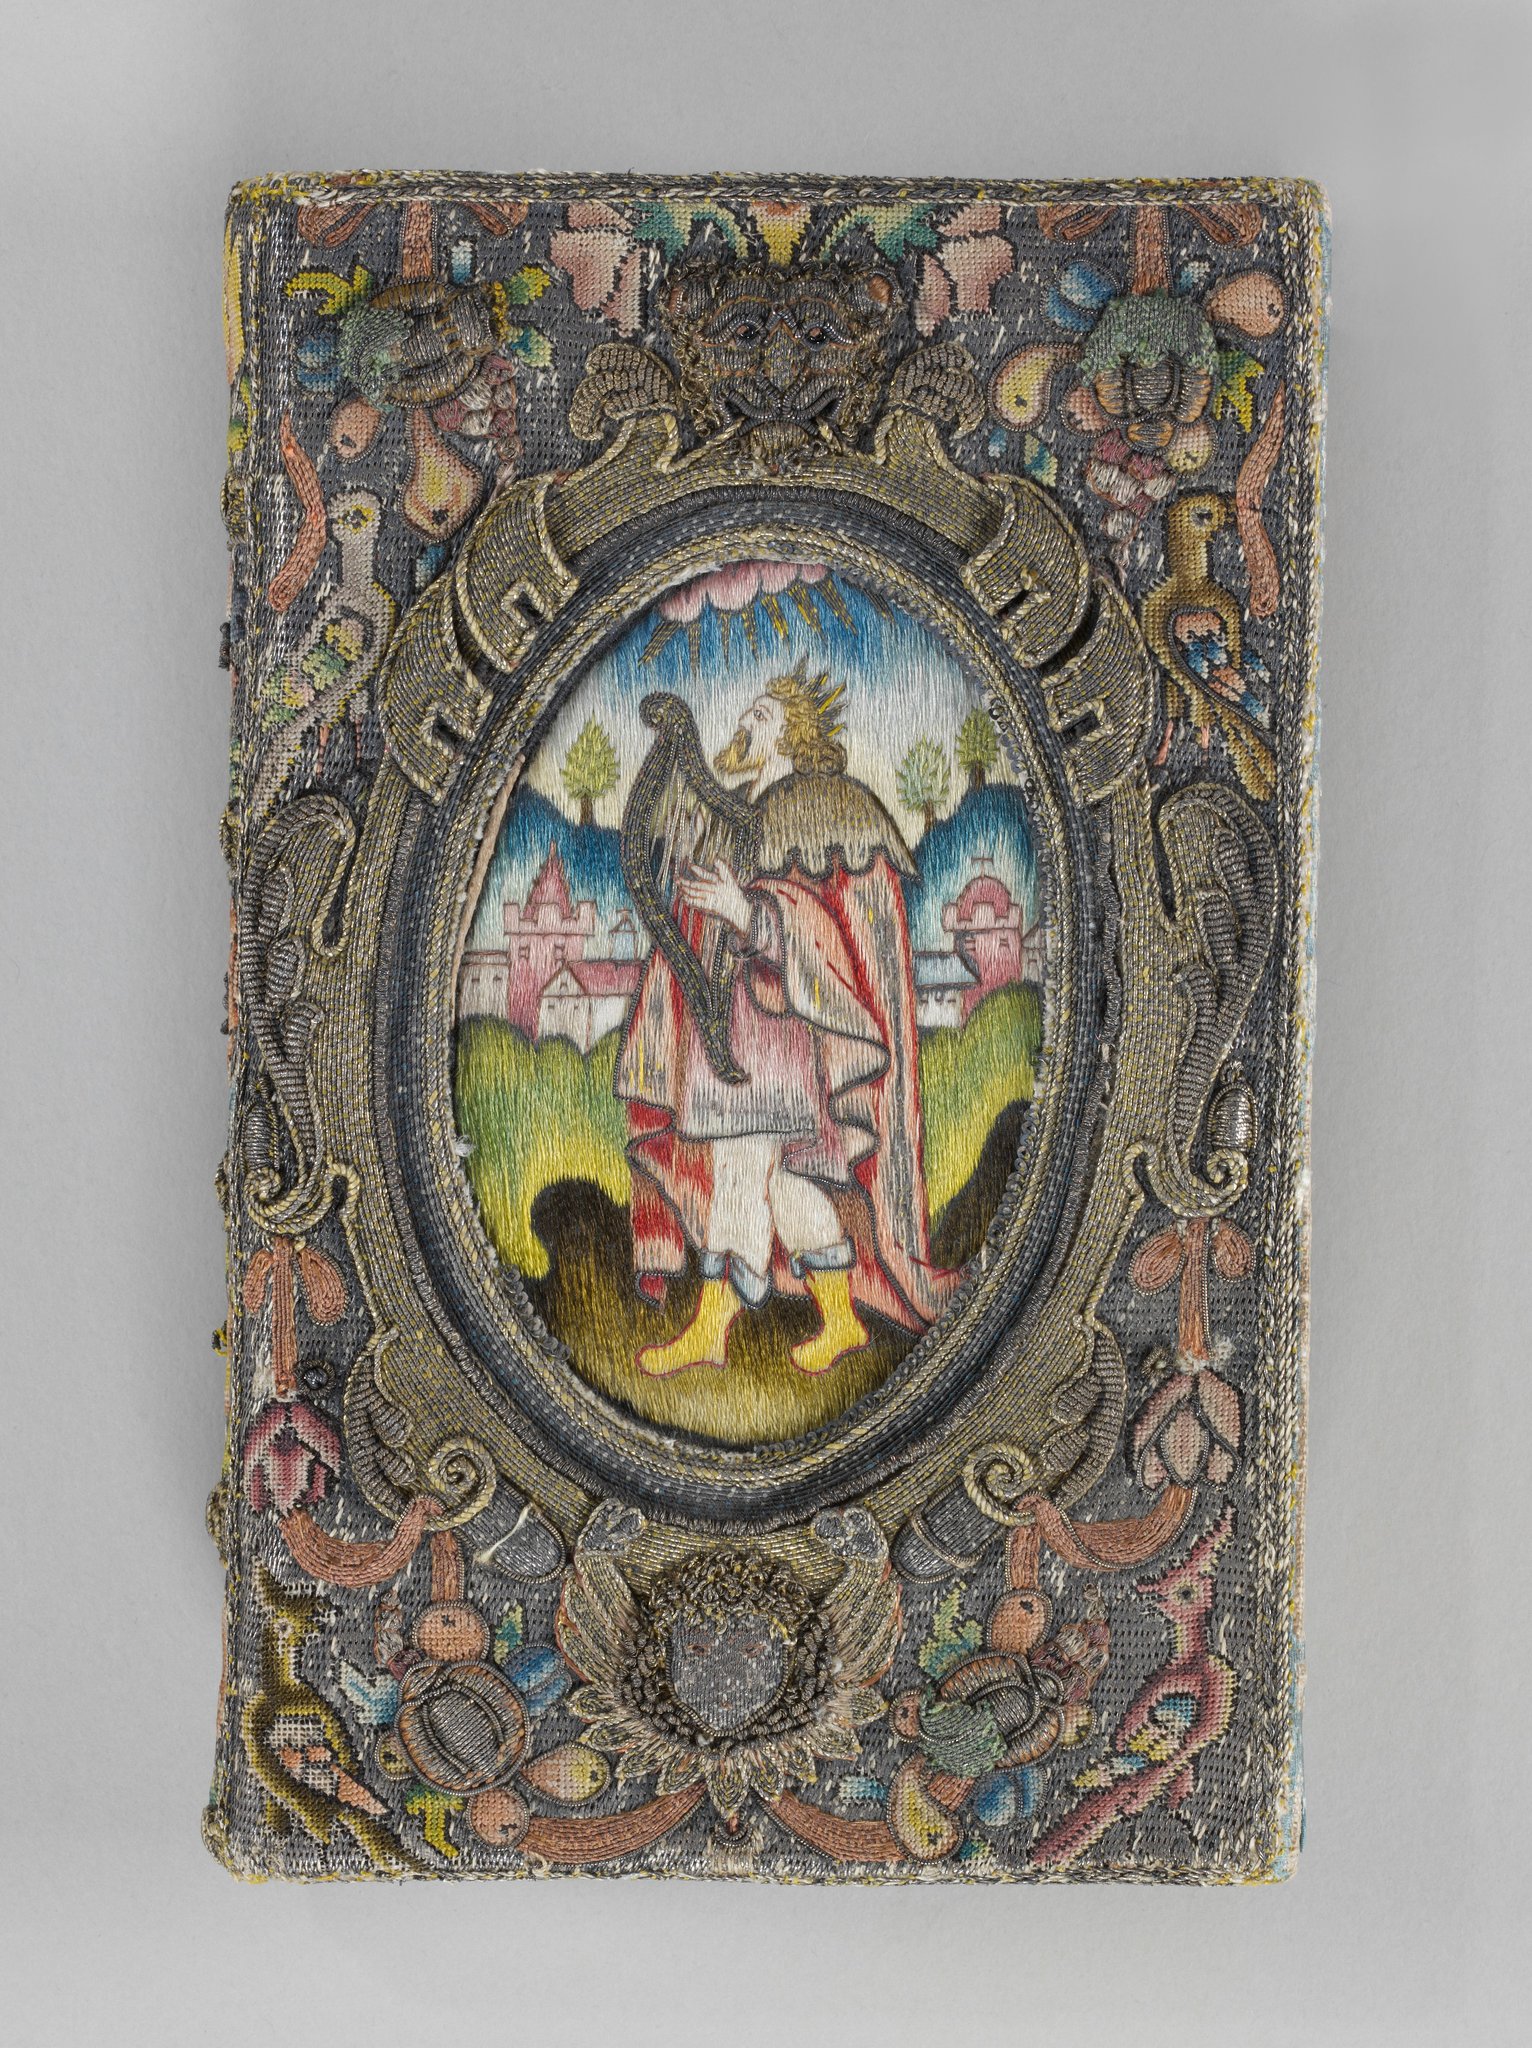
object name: book cover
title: The New Testament, The Book of Common Prayer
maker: robert barker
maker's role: printer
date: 1636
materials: canvas, textile, silk, silver, silver gilt, thread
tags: musical instruments,birds,men